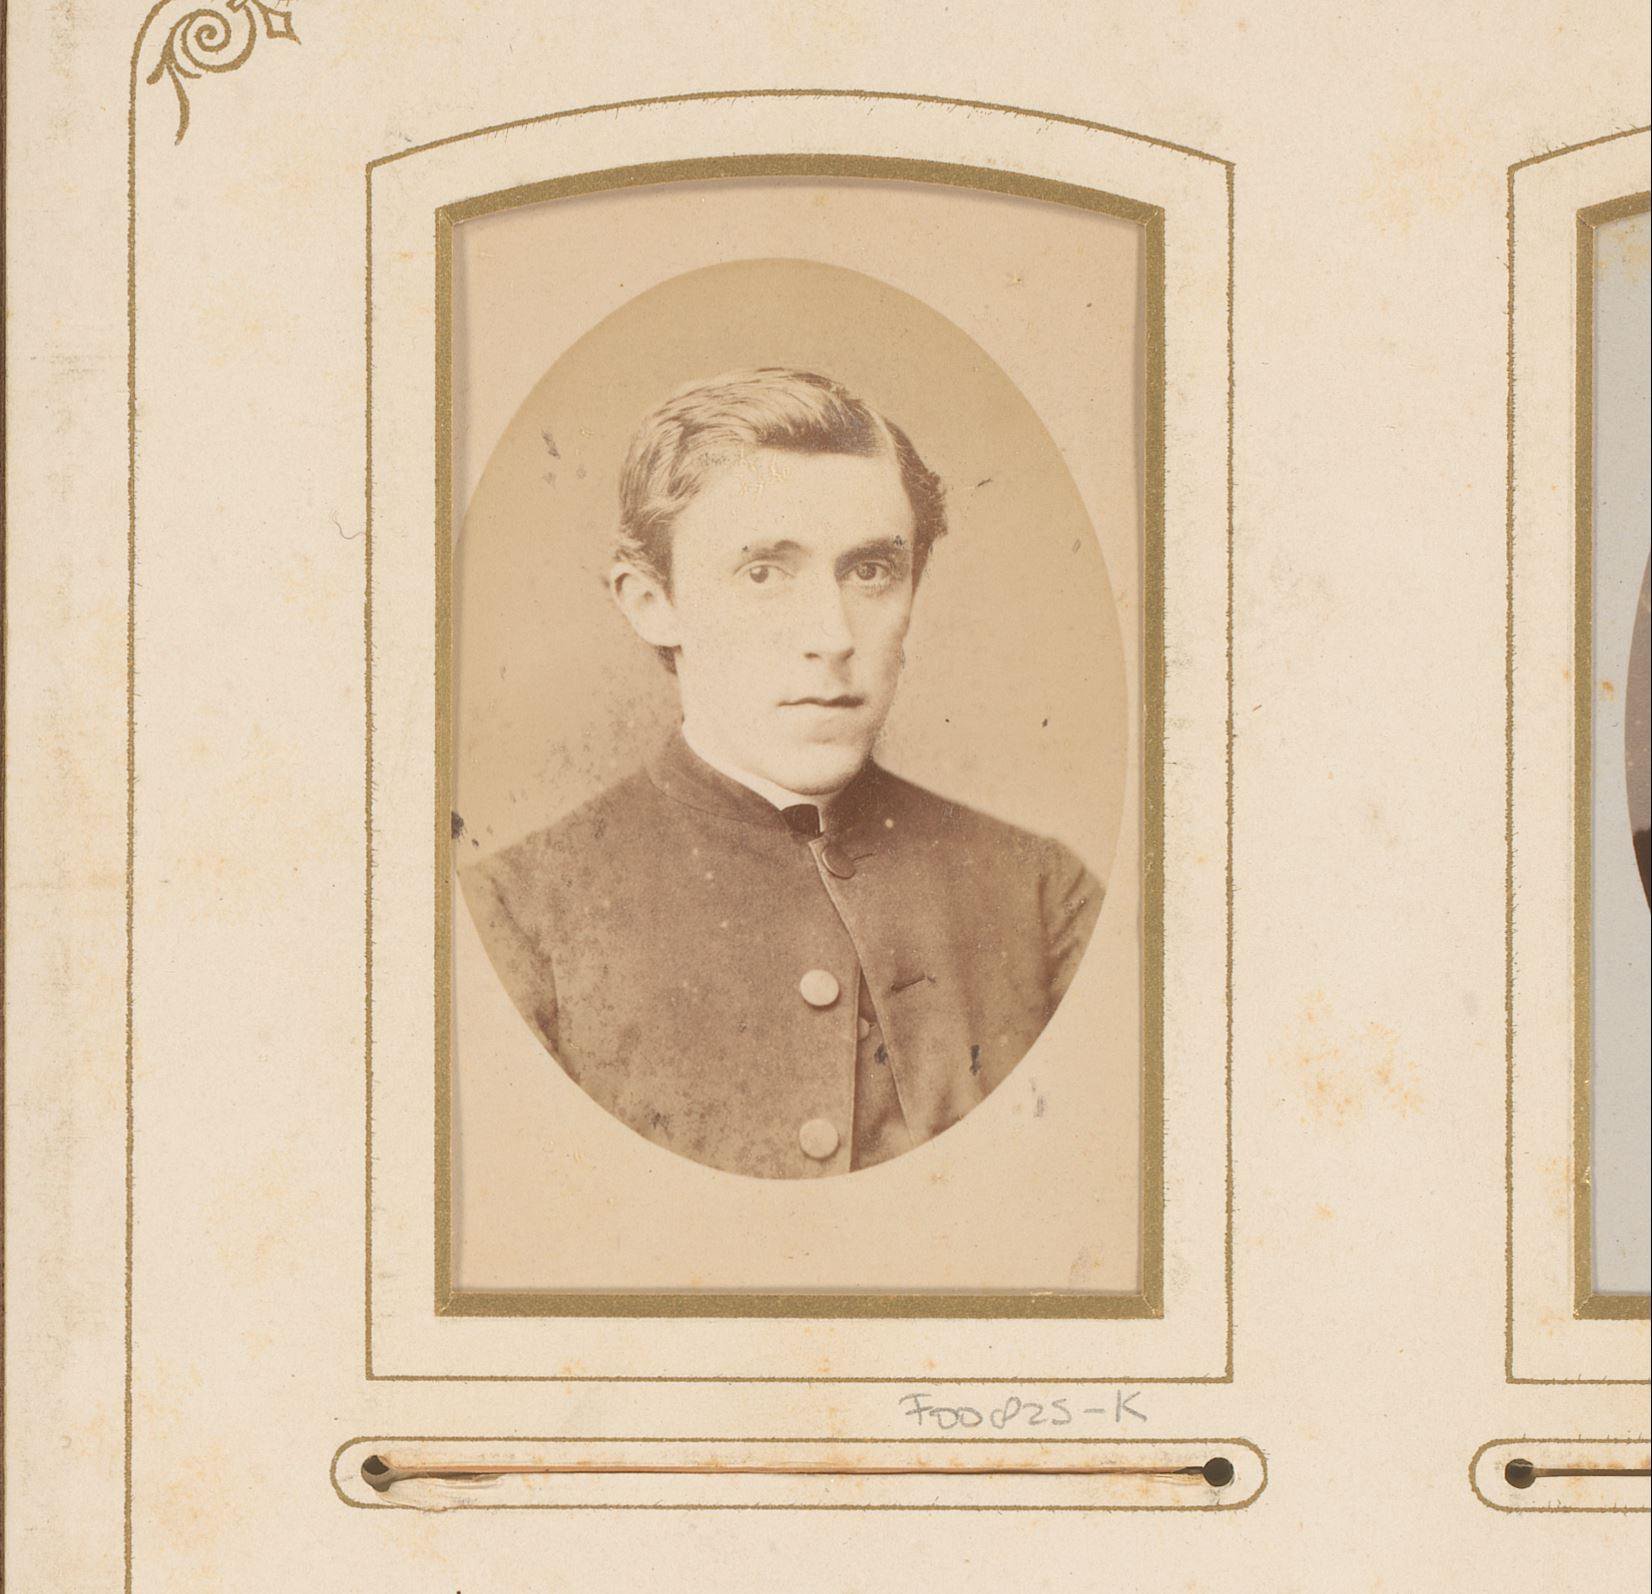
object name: album leaf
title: Portret van een geestelijke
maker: christiaan martinus jan hermelink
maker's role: fotograaf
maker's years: 1840-1933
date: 1867-1885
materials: cardboard, photographic support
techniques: albumen print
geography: the hague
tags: theologian, historical persons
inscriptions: inscription: ‘C.M.J. HERMELINK/ 62, Denneweg/ LA HAYE’